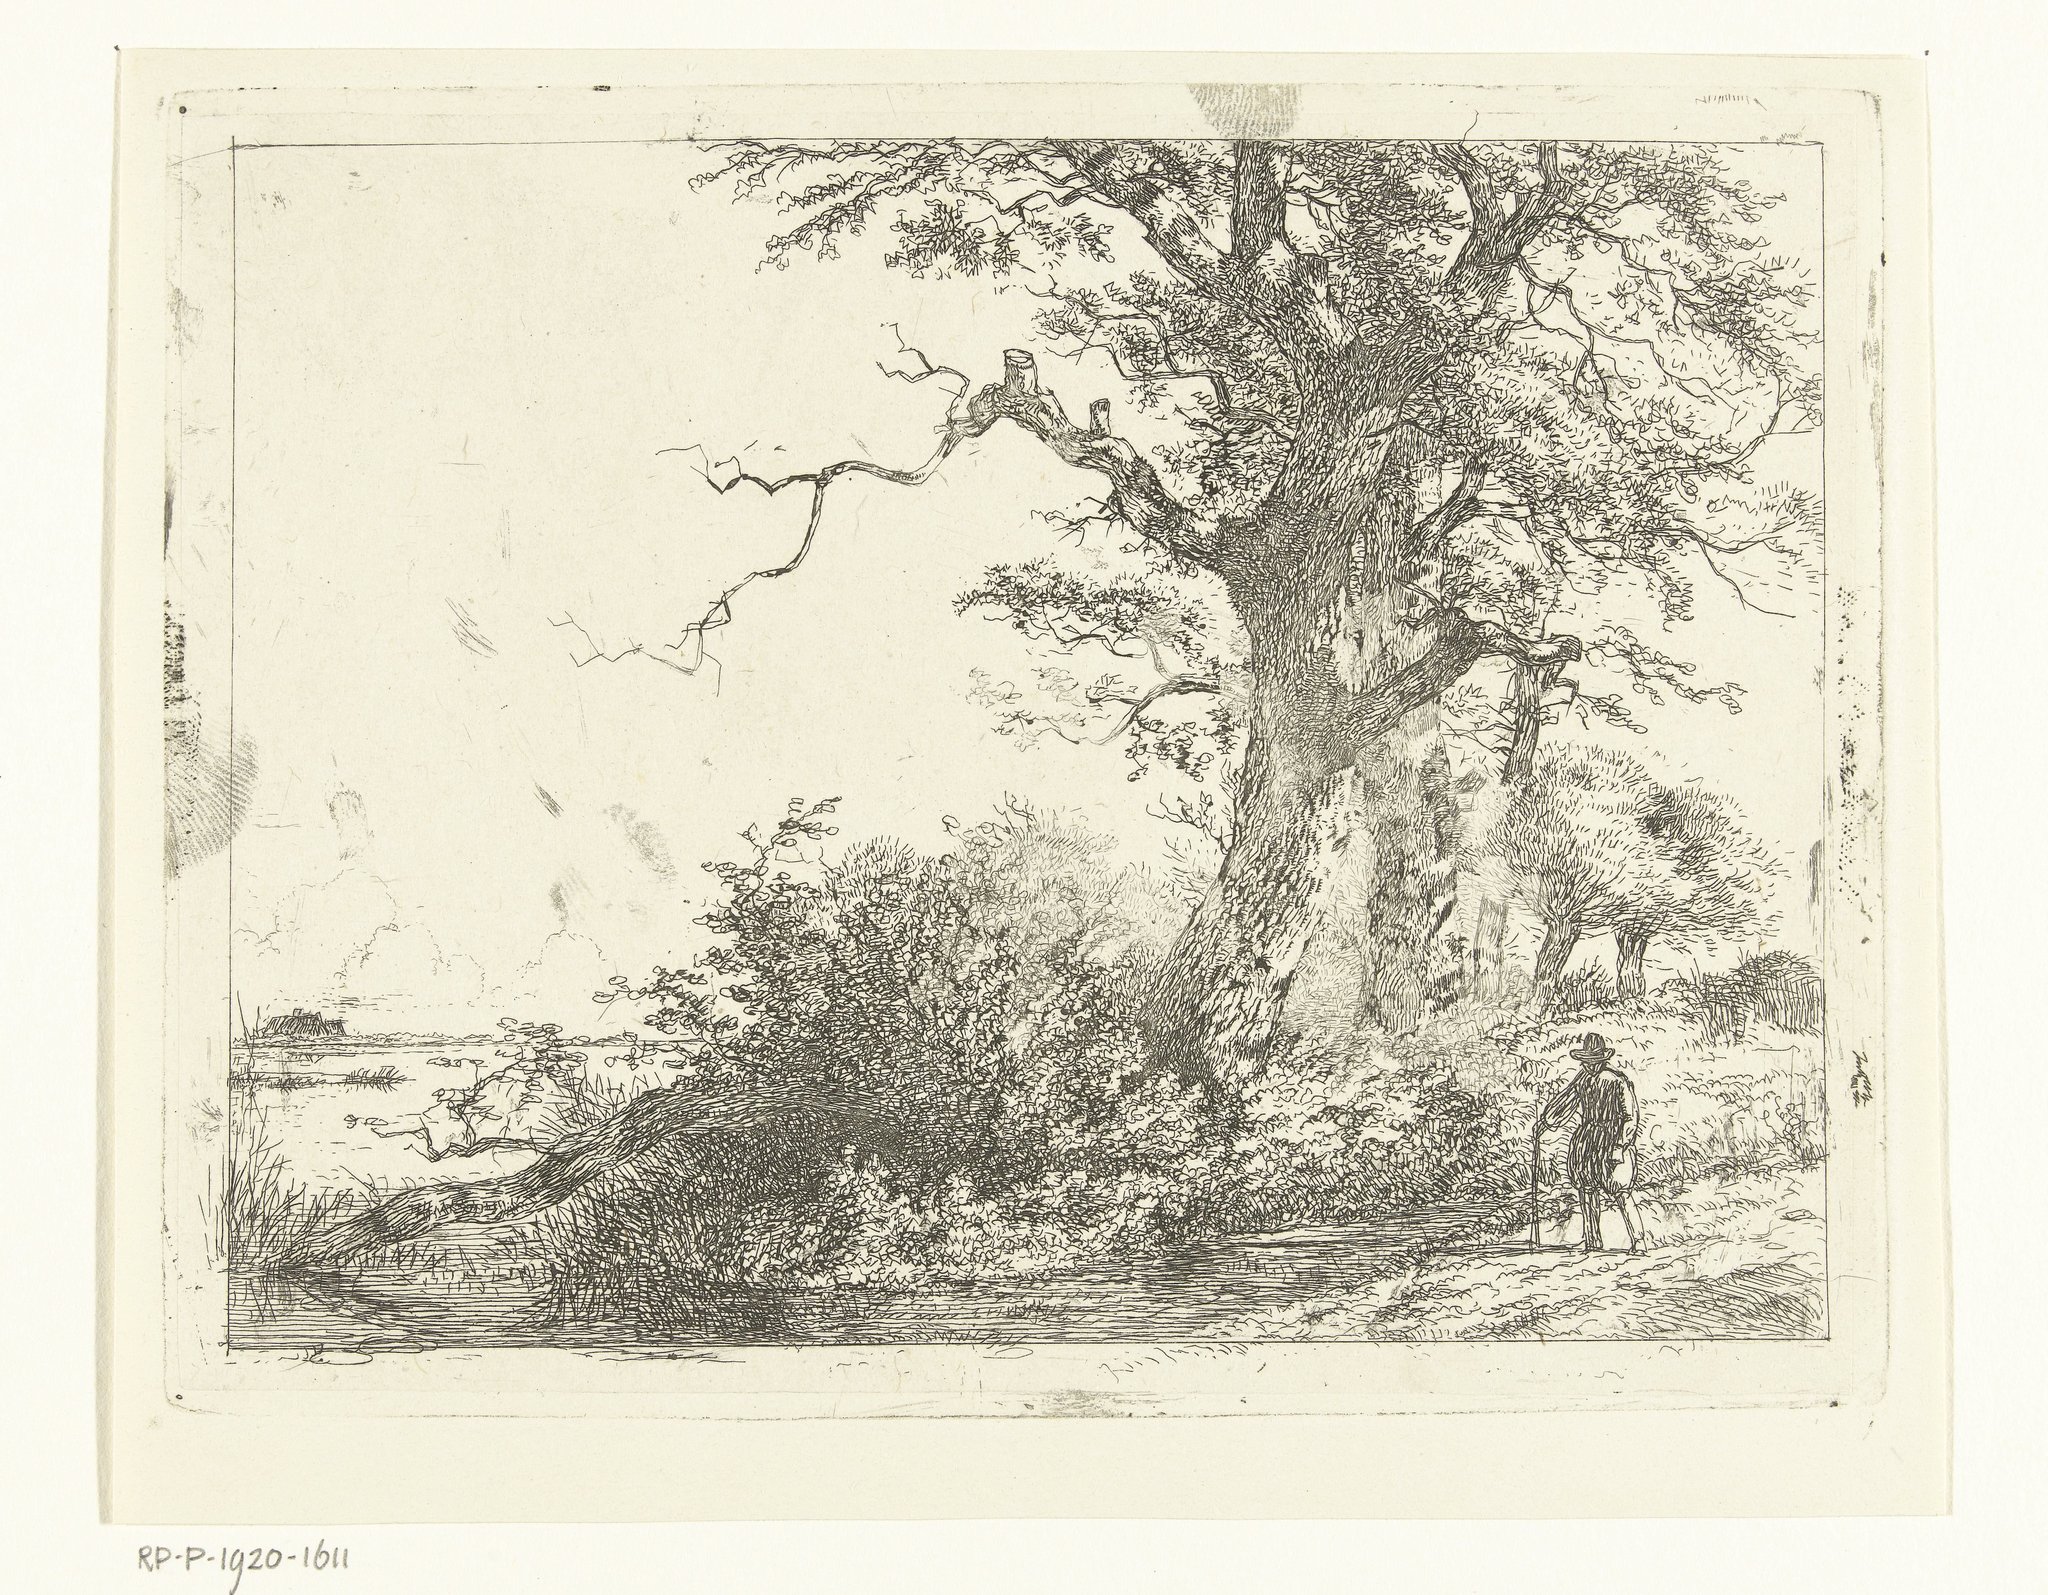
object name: print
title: Landschap met eikebomen en man bij water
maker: albertus brondgeest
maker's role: draughtsman, print maker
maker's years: 1786-1849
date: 1796-1849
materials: paper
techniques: etching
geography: netherlands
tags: water course, groups of trees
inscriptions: collector's mark: Lugt 2228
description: Op de druk zijn een aantal vingerafdrukken van de kunstenaar zichtbaar. Deze bevonden zich waarschijnlijk in de etsgrond en zijn na het etsen met zuur zichtbaar geworden op de plaat want een tweede druk vertoont precies dezelfde afdrukken (vergelijk RP-P-1878-A-689).